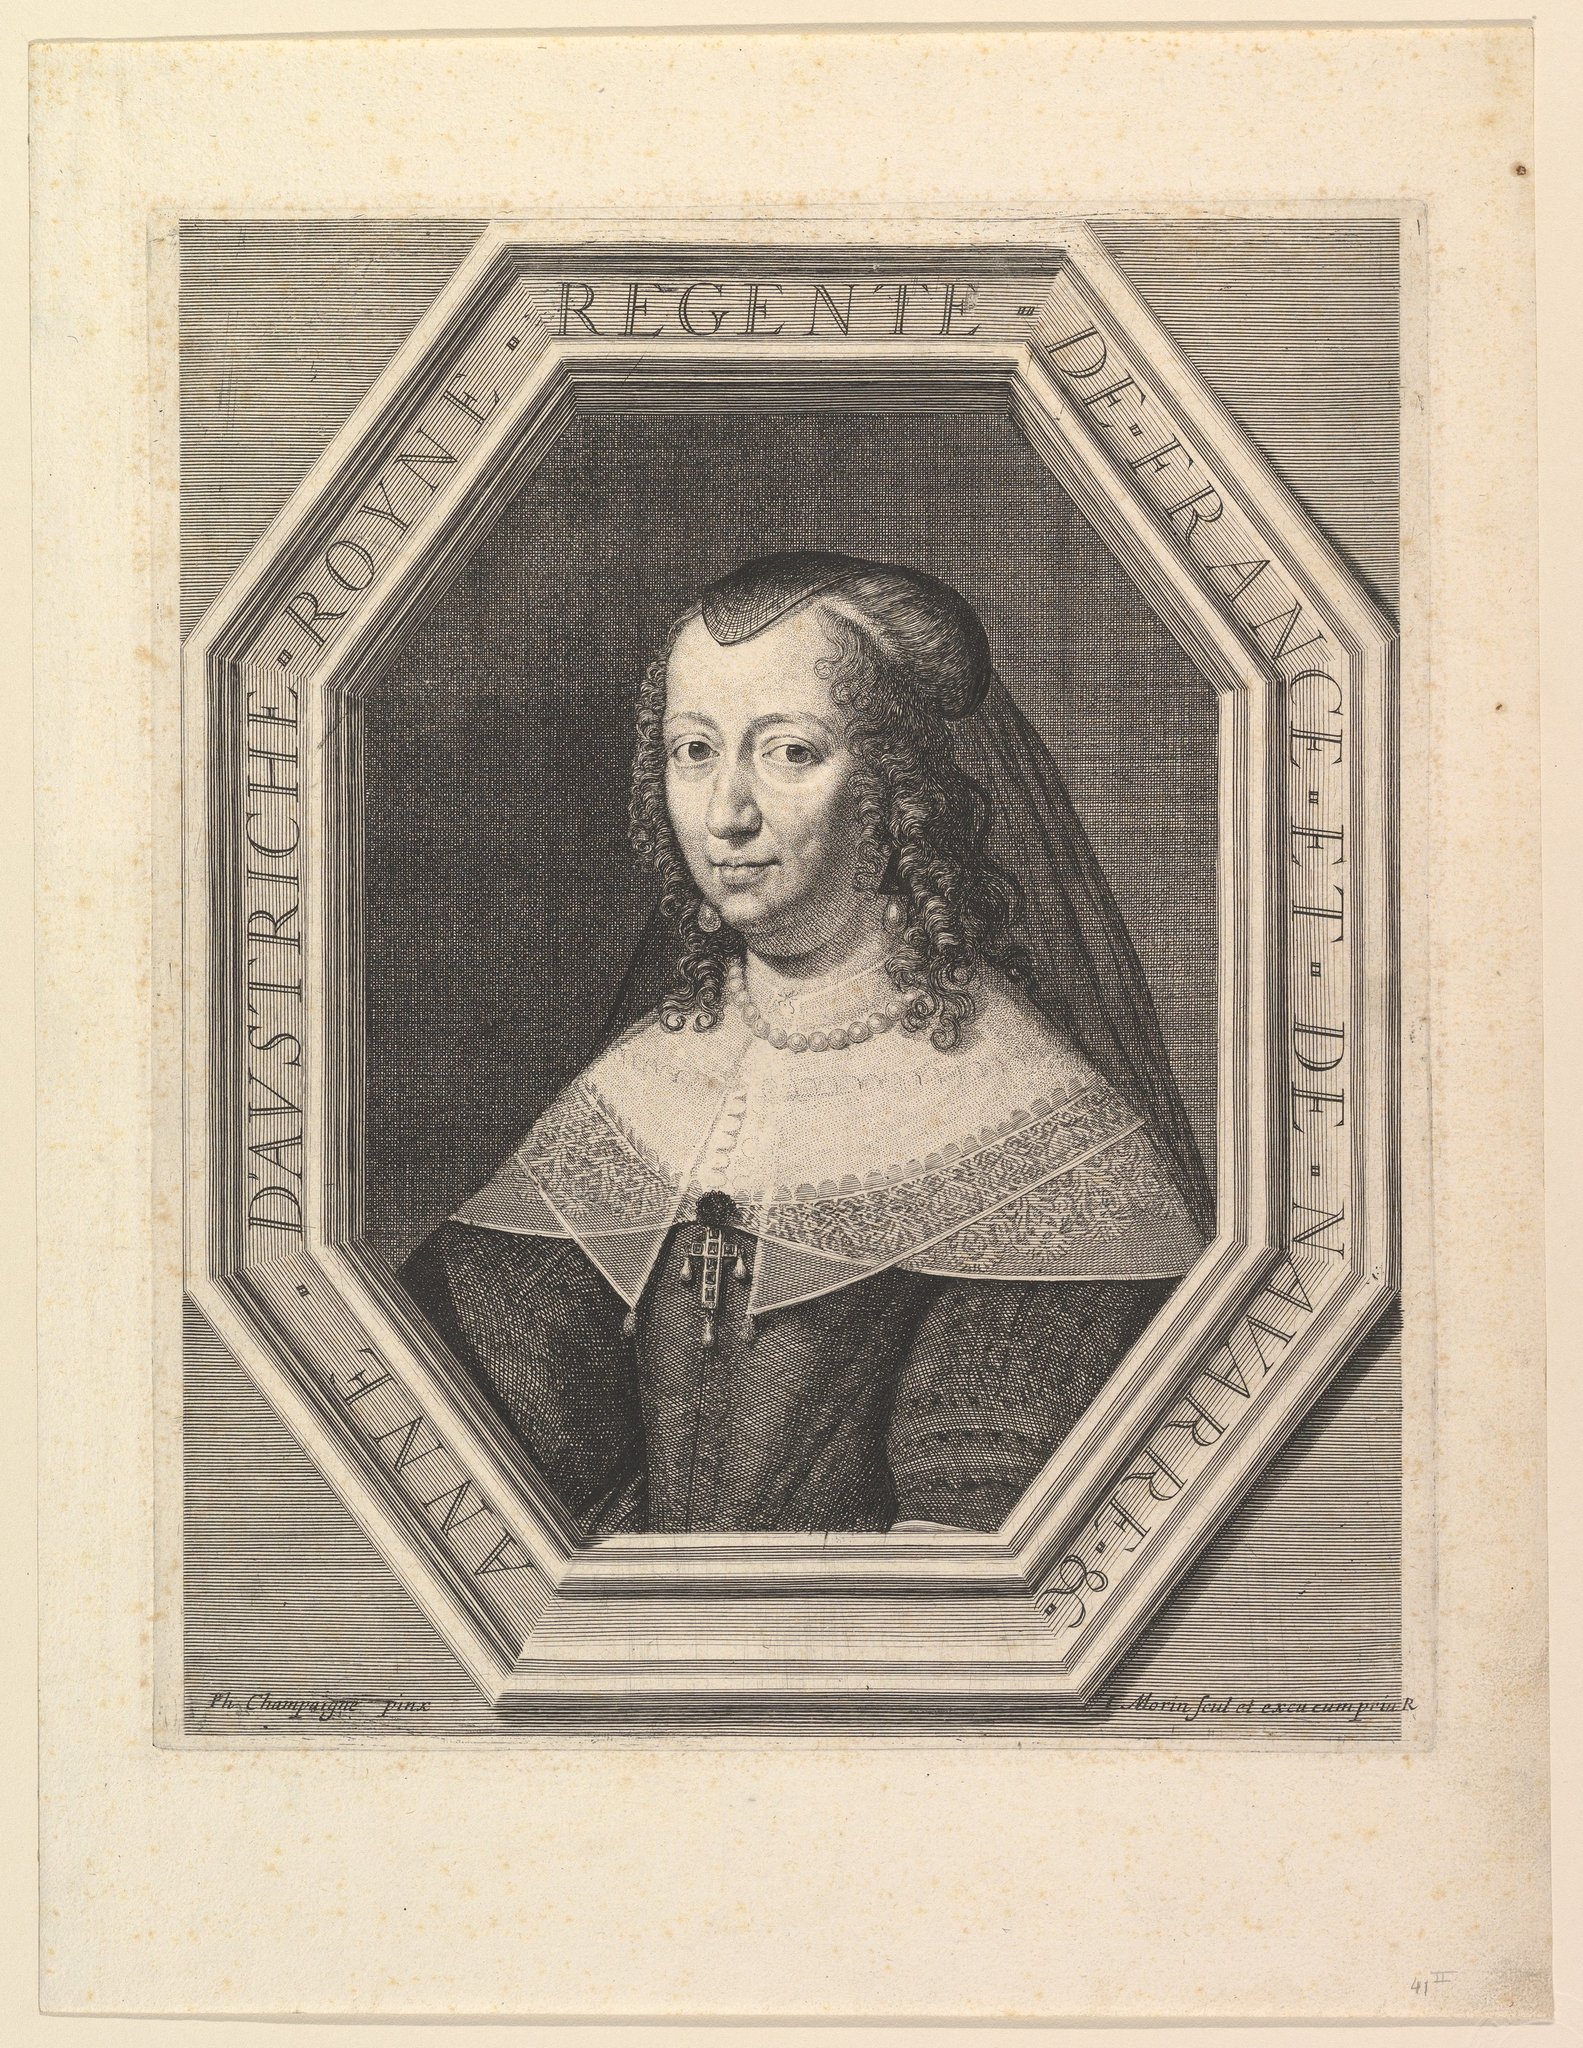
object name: print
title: Anne d'Autriche, reine de France, en deuil de cour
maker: jean morin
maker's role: artist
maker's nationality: french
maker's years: 1605-1650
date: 1605-1650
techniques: etching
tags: portraits,women